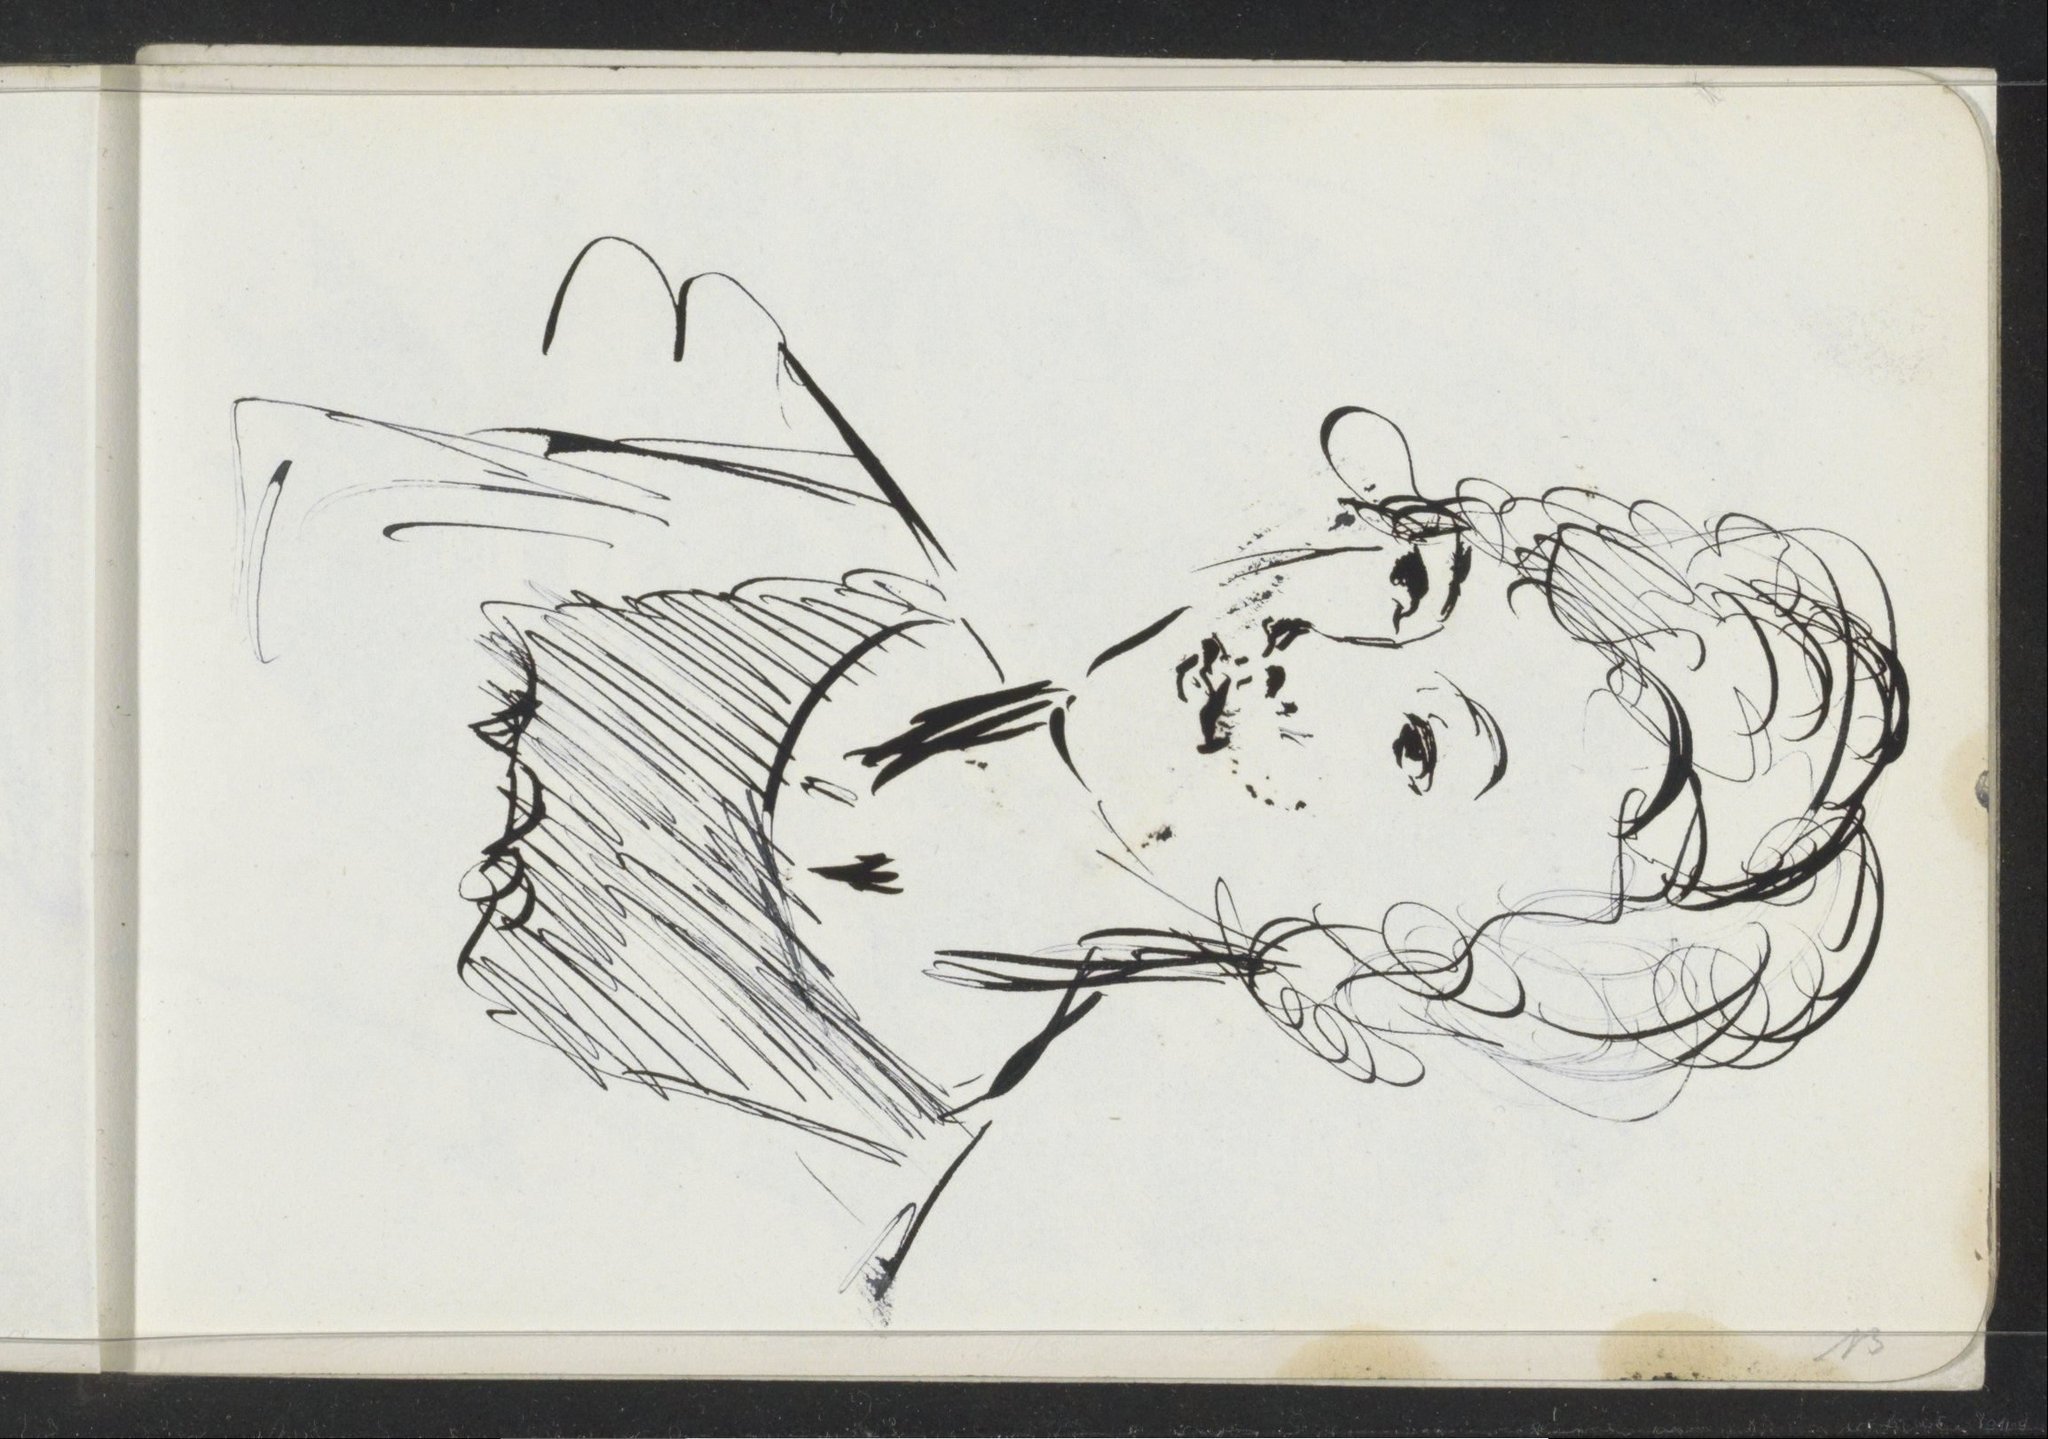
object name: sketchbook leaf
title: Vrouwenhoofd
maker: isaac israels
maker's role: draughtsman, painter, print maker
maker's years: 1865-1934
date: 1875-1934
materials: ink, paper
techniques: pen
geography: the hague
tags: head (human) - aa - female human figure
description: Blad 13 recto uit schetsboek LX met 33 bladen.